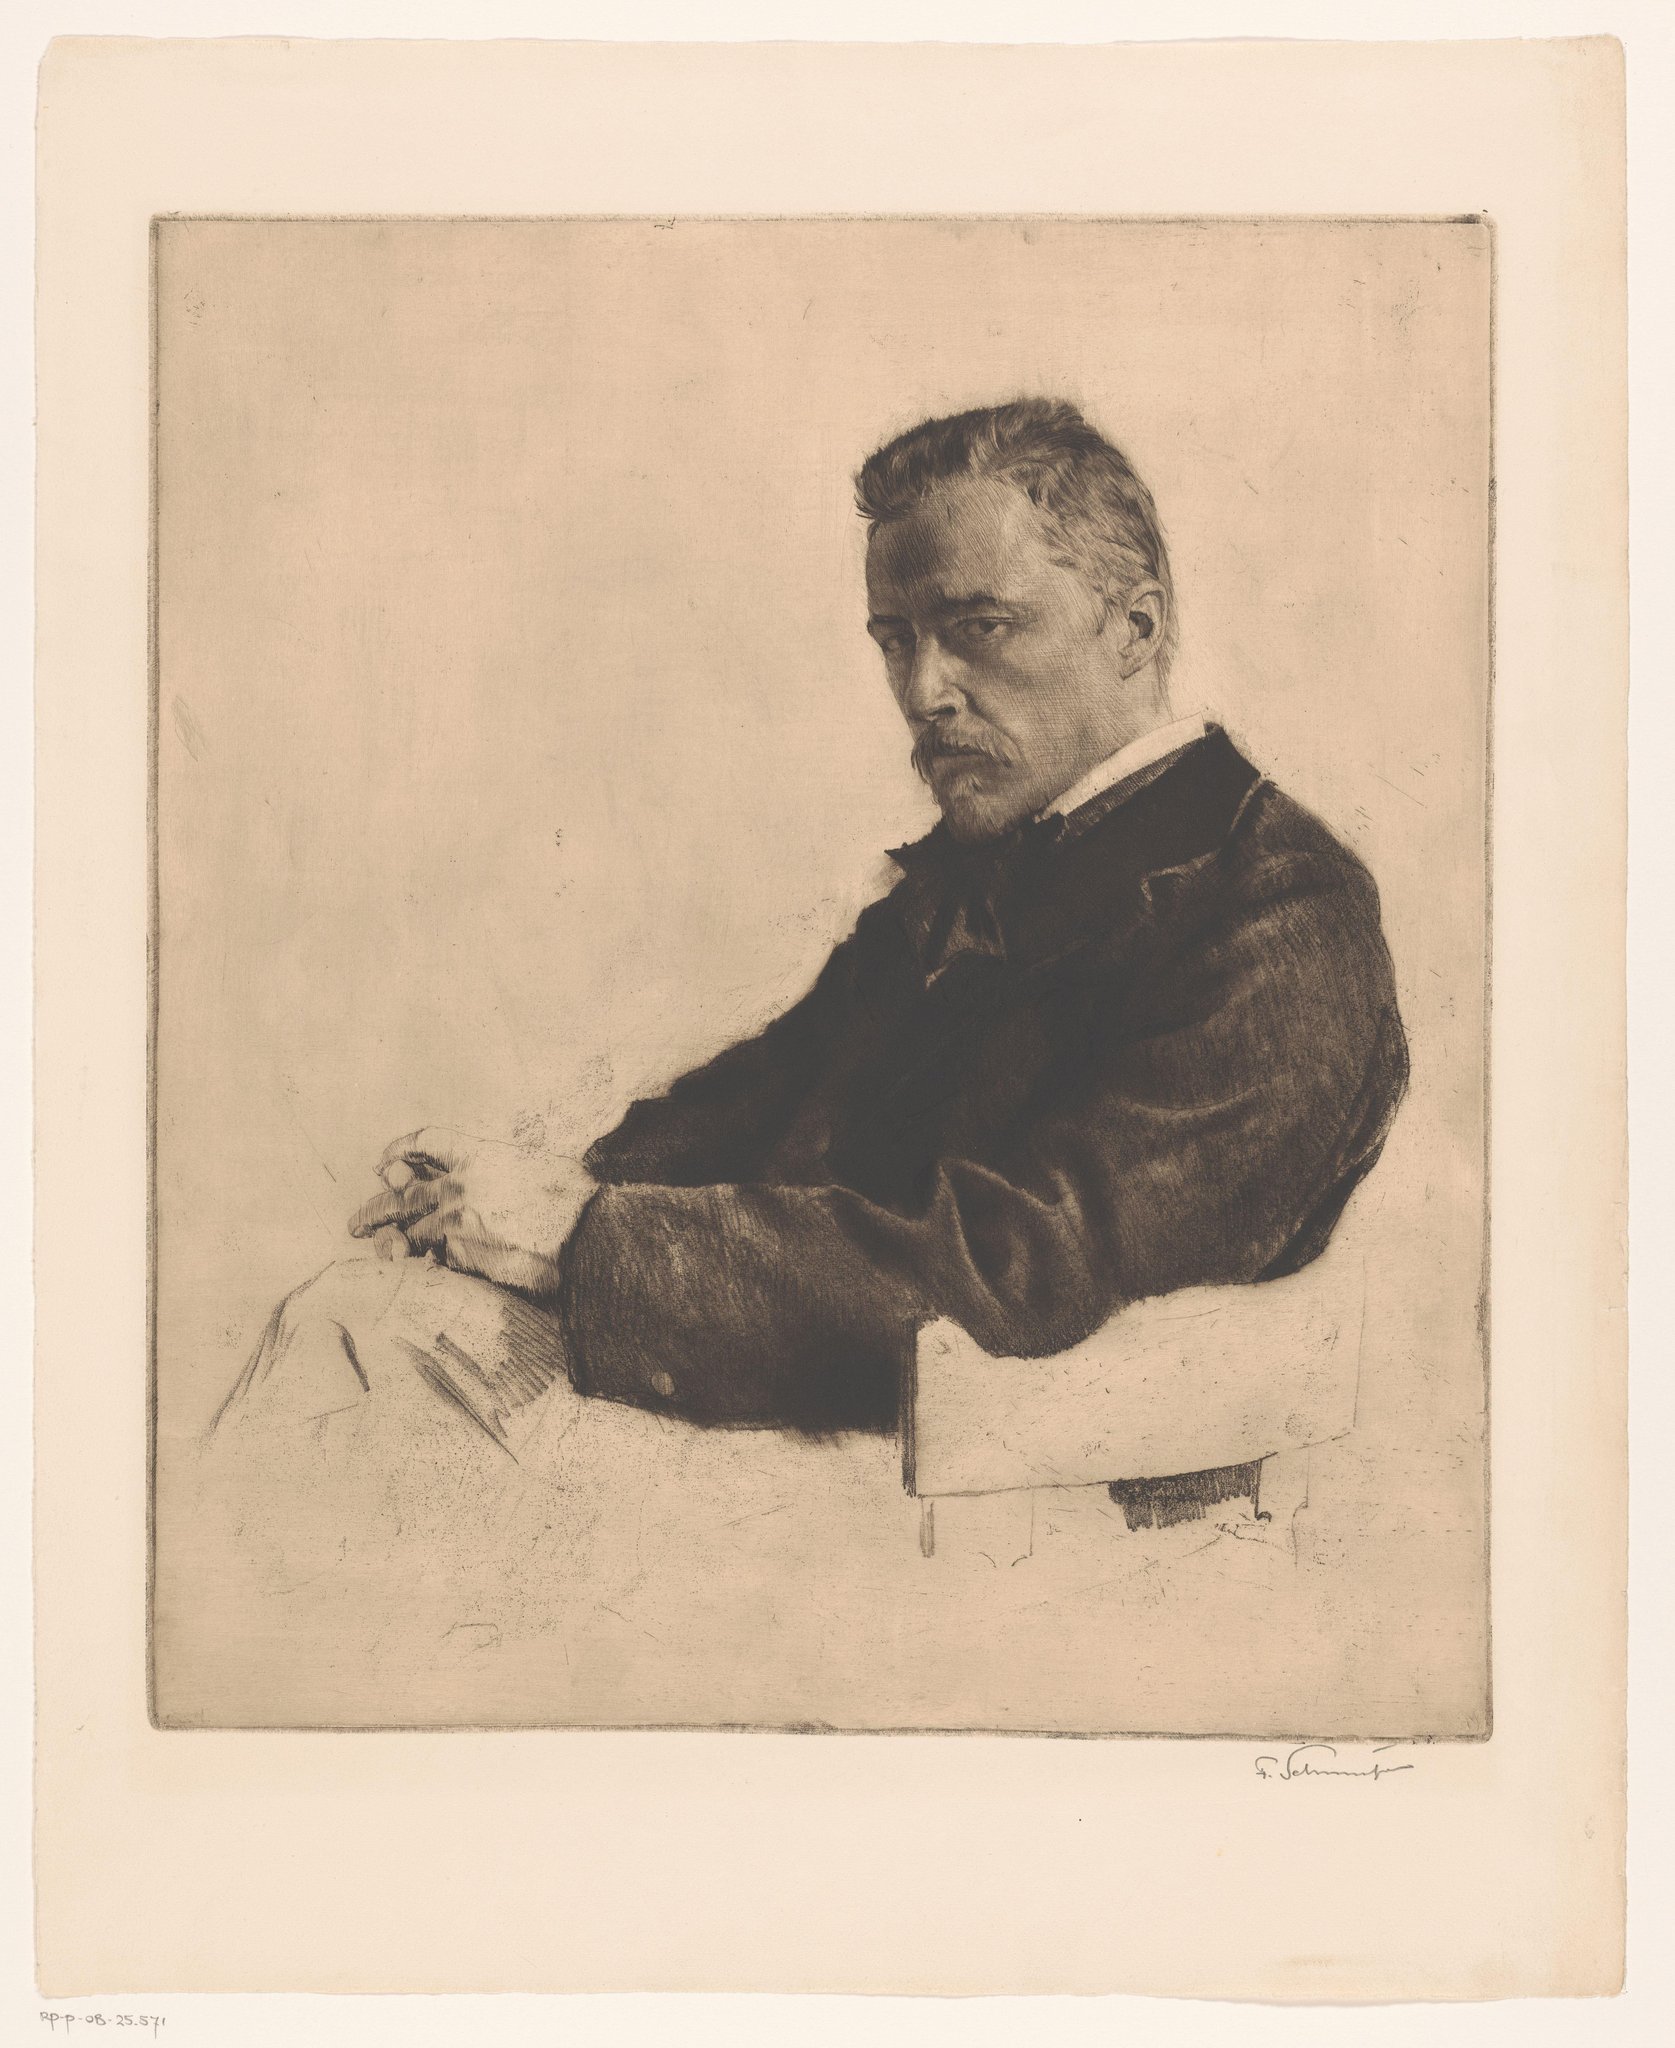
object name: print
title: Portret van Hugo Wolf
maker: ferdinand schmutzer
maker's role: painter, print maker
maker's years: 1870-1928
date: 1880-1928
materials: paper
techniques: etching, soft ground etching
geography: vienna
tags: portrait of composer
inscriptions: collector's mark: Lugt 2228